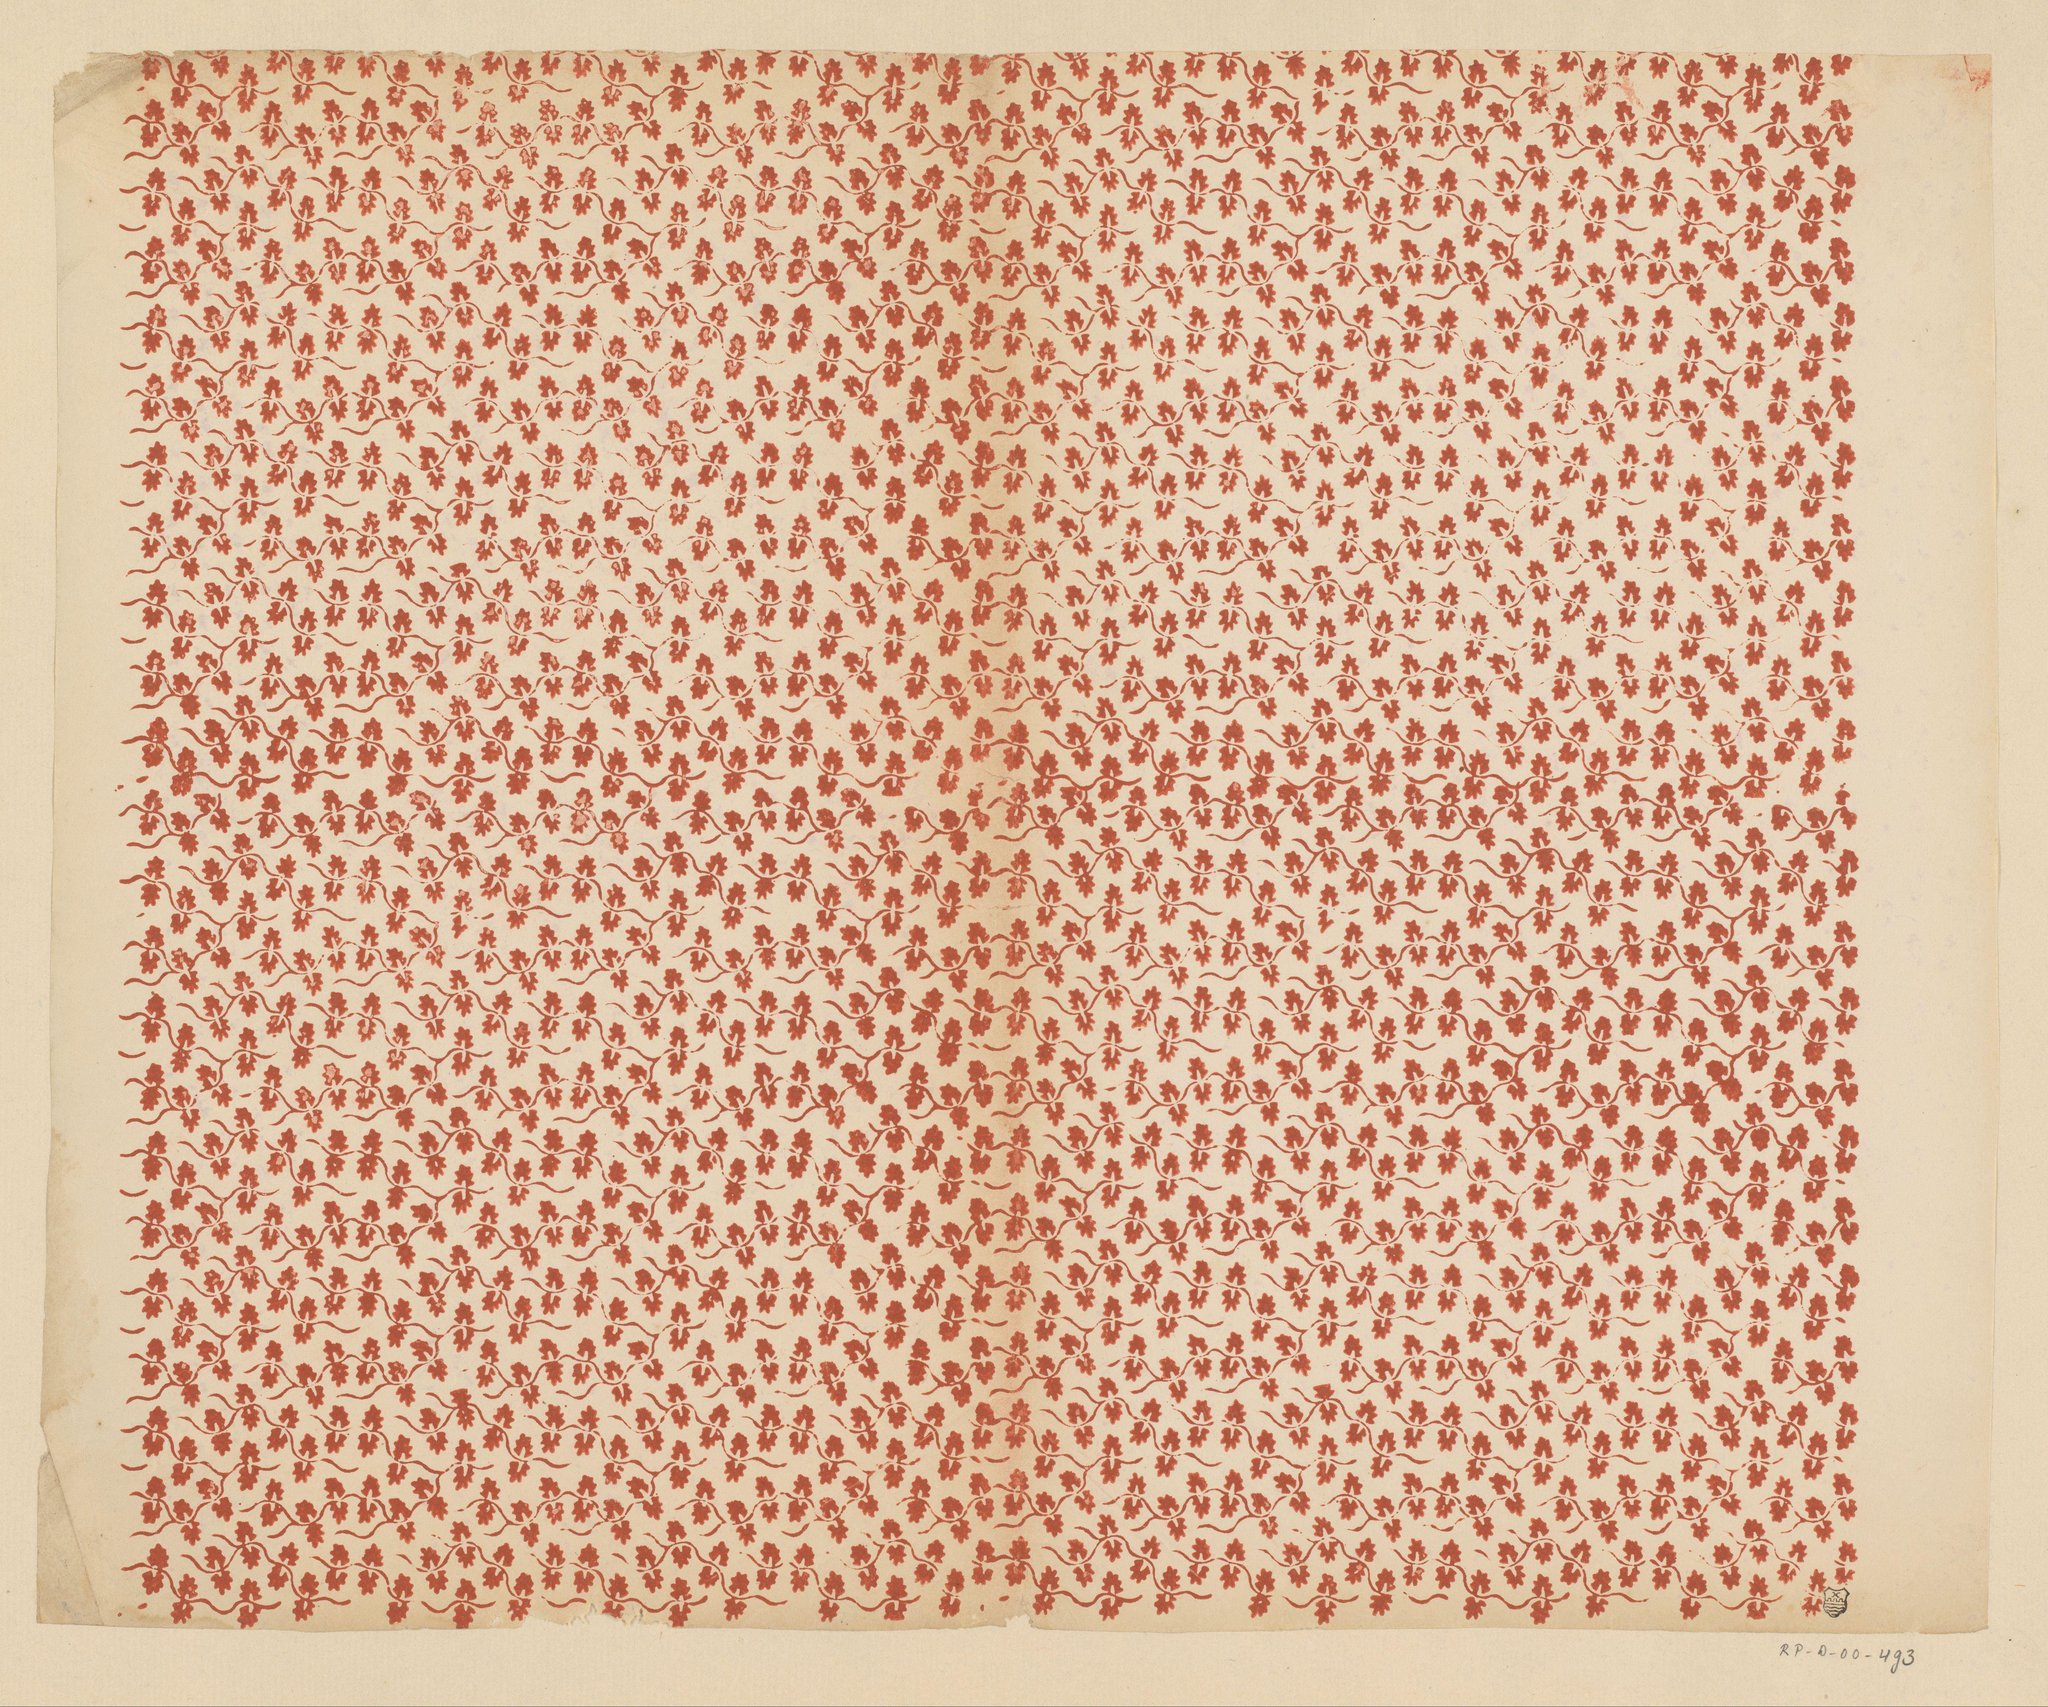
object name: printed paper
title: Blad met strooipatroon van rank met bladeren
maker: Anonymous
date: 1800-1900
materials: paper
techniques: printing block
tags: ornament derived from plant forms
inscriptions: collector's mark: Lugt 2760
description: Blad met strooipatroon van rank met eikenbladeren.